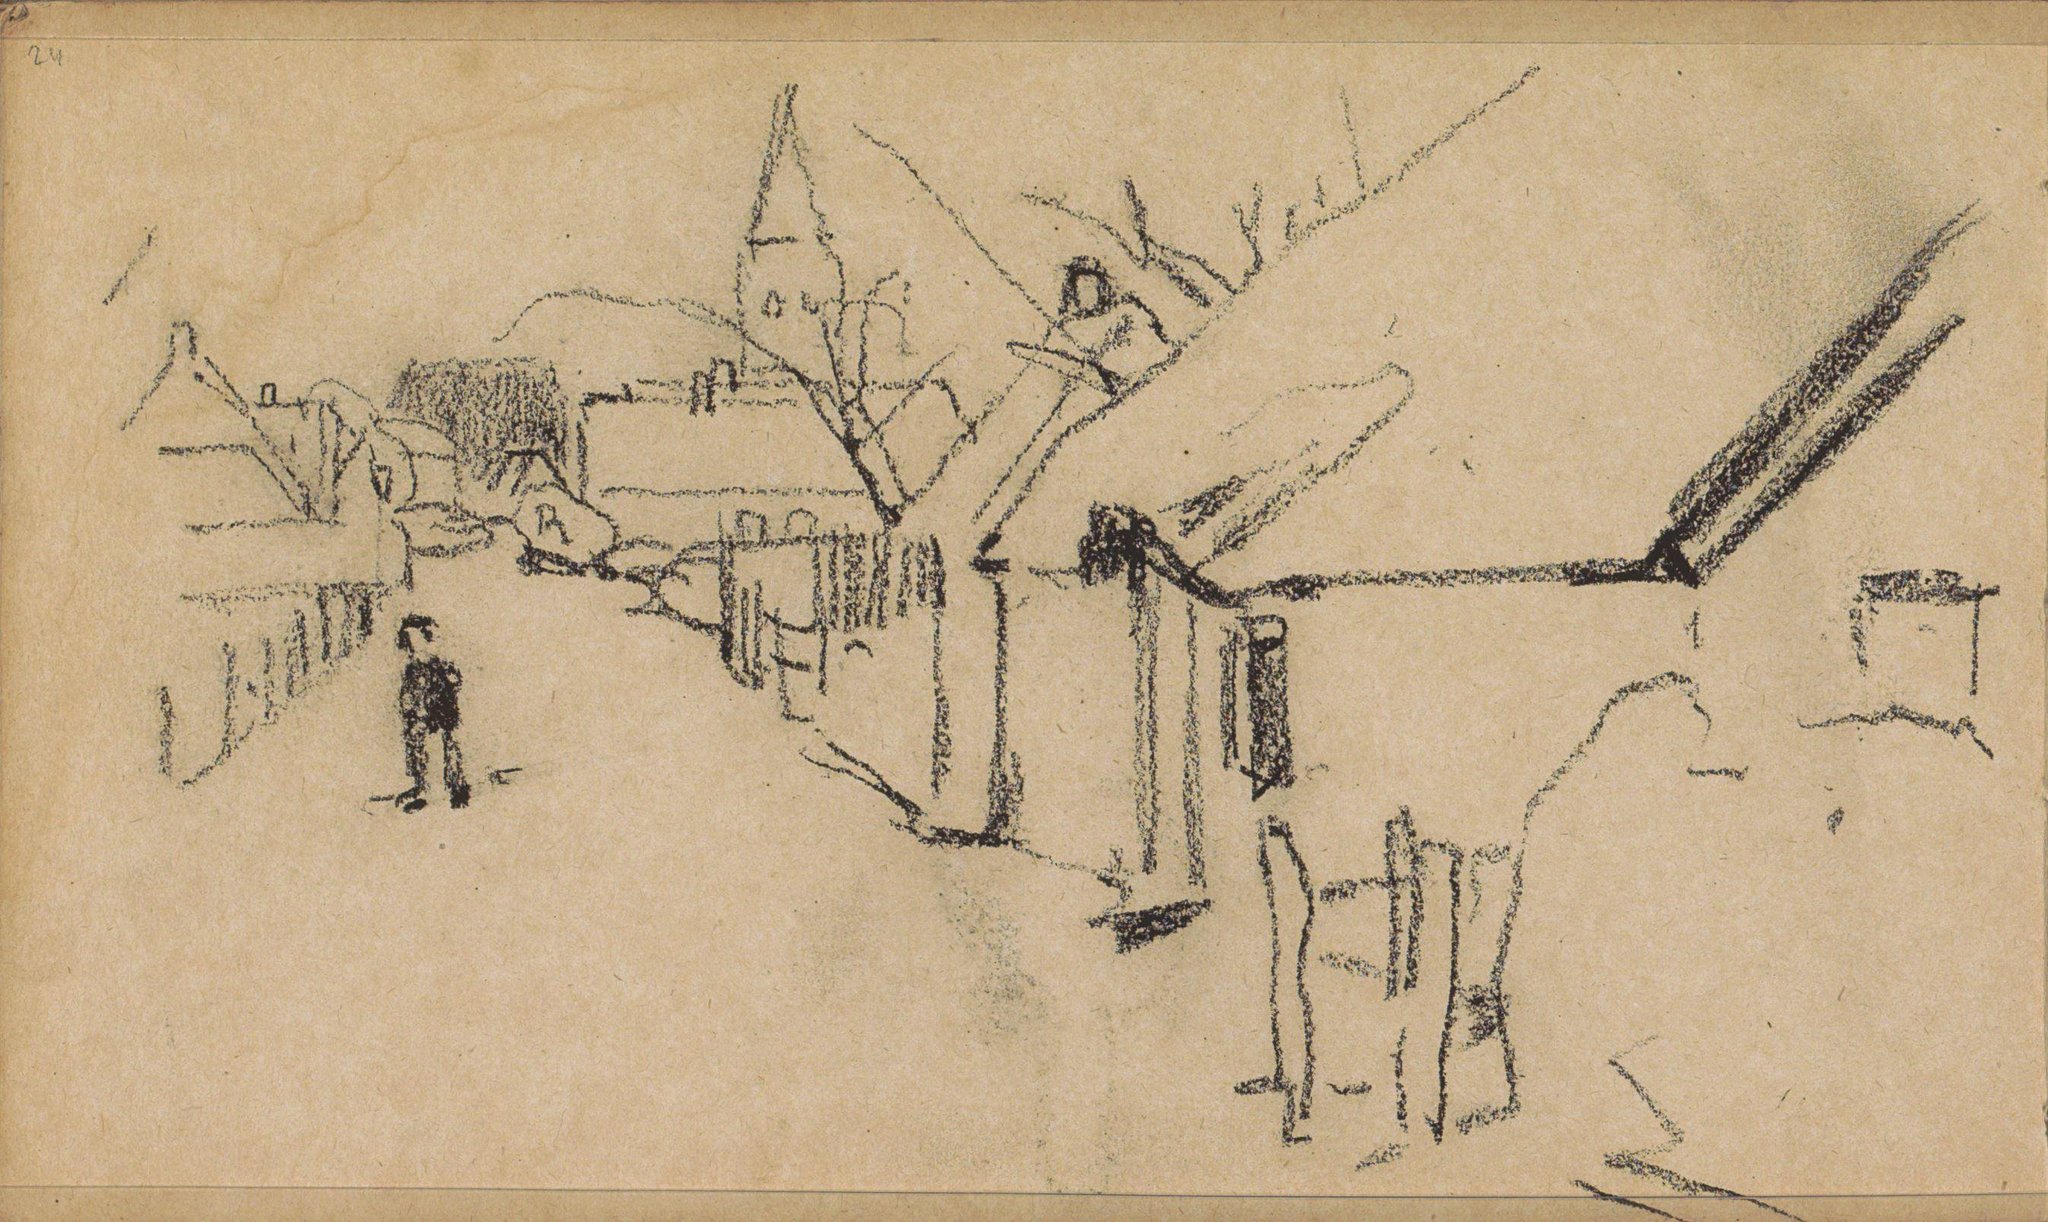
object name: sketchbook leaf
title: Dorpsstraat met een kerk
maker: willem witsen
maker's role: draughtsman, painter, print maker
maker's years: 1860-1923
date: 1888-1891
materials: chalk, paper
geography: amsterdam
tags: church (exterior), village street (+ city(-scape) with figures, staffage)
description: Pagina 24 uit een schetsboek met 27 bladen.